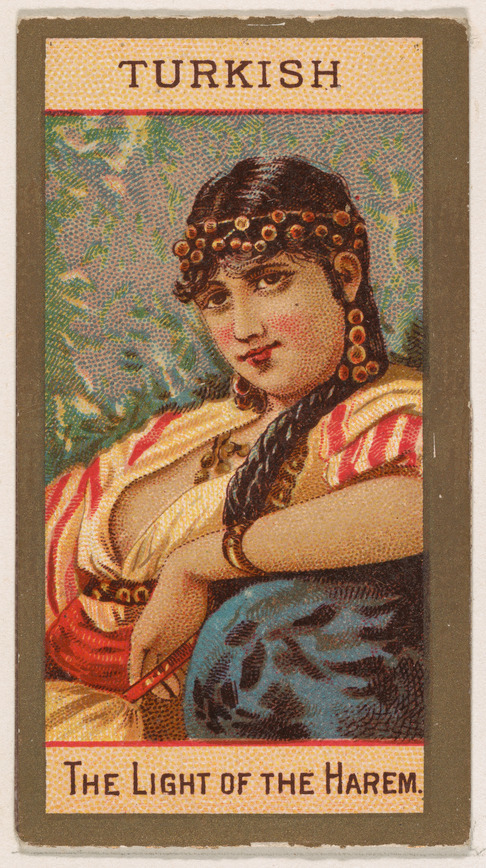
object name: print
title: Turkish, The Light of the Harem, from Types of Nationalities (N240) issued by Kinney Bros.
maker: kinney brothers tobacco company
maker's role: publisher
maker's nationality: american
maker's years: 1869-2011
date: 1890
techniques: color lithograph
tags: women